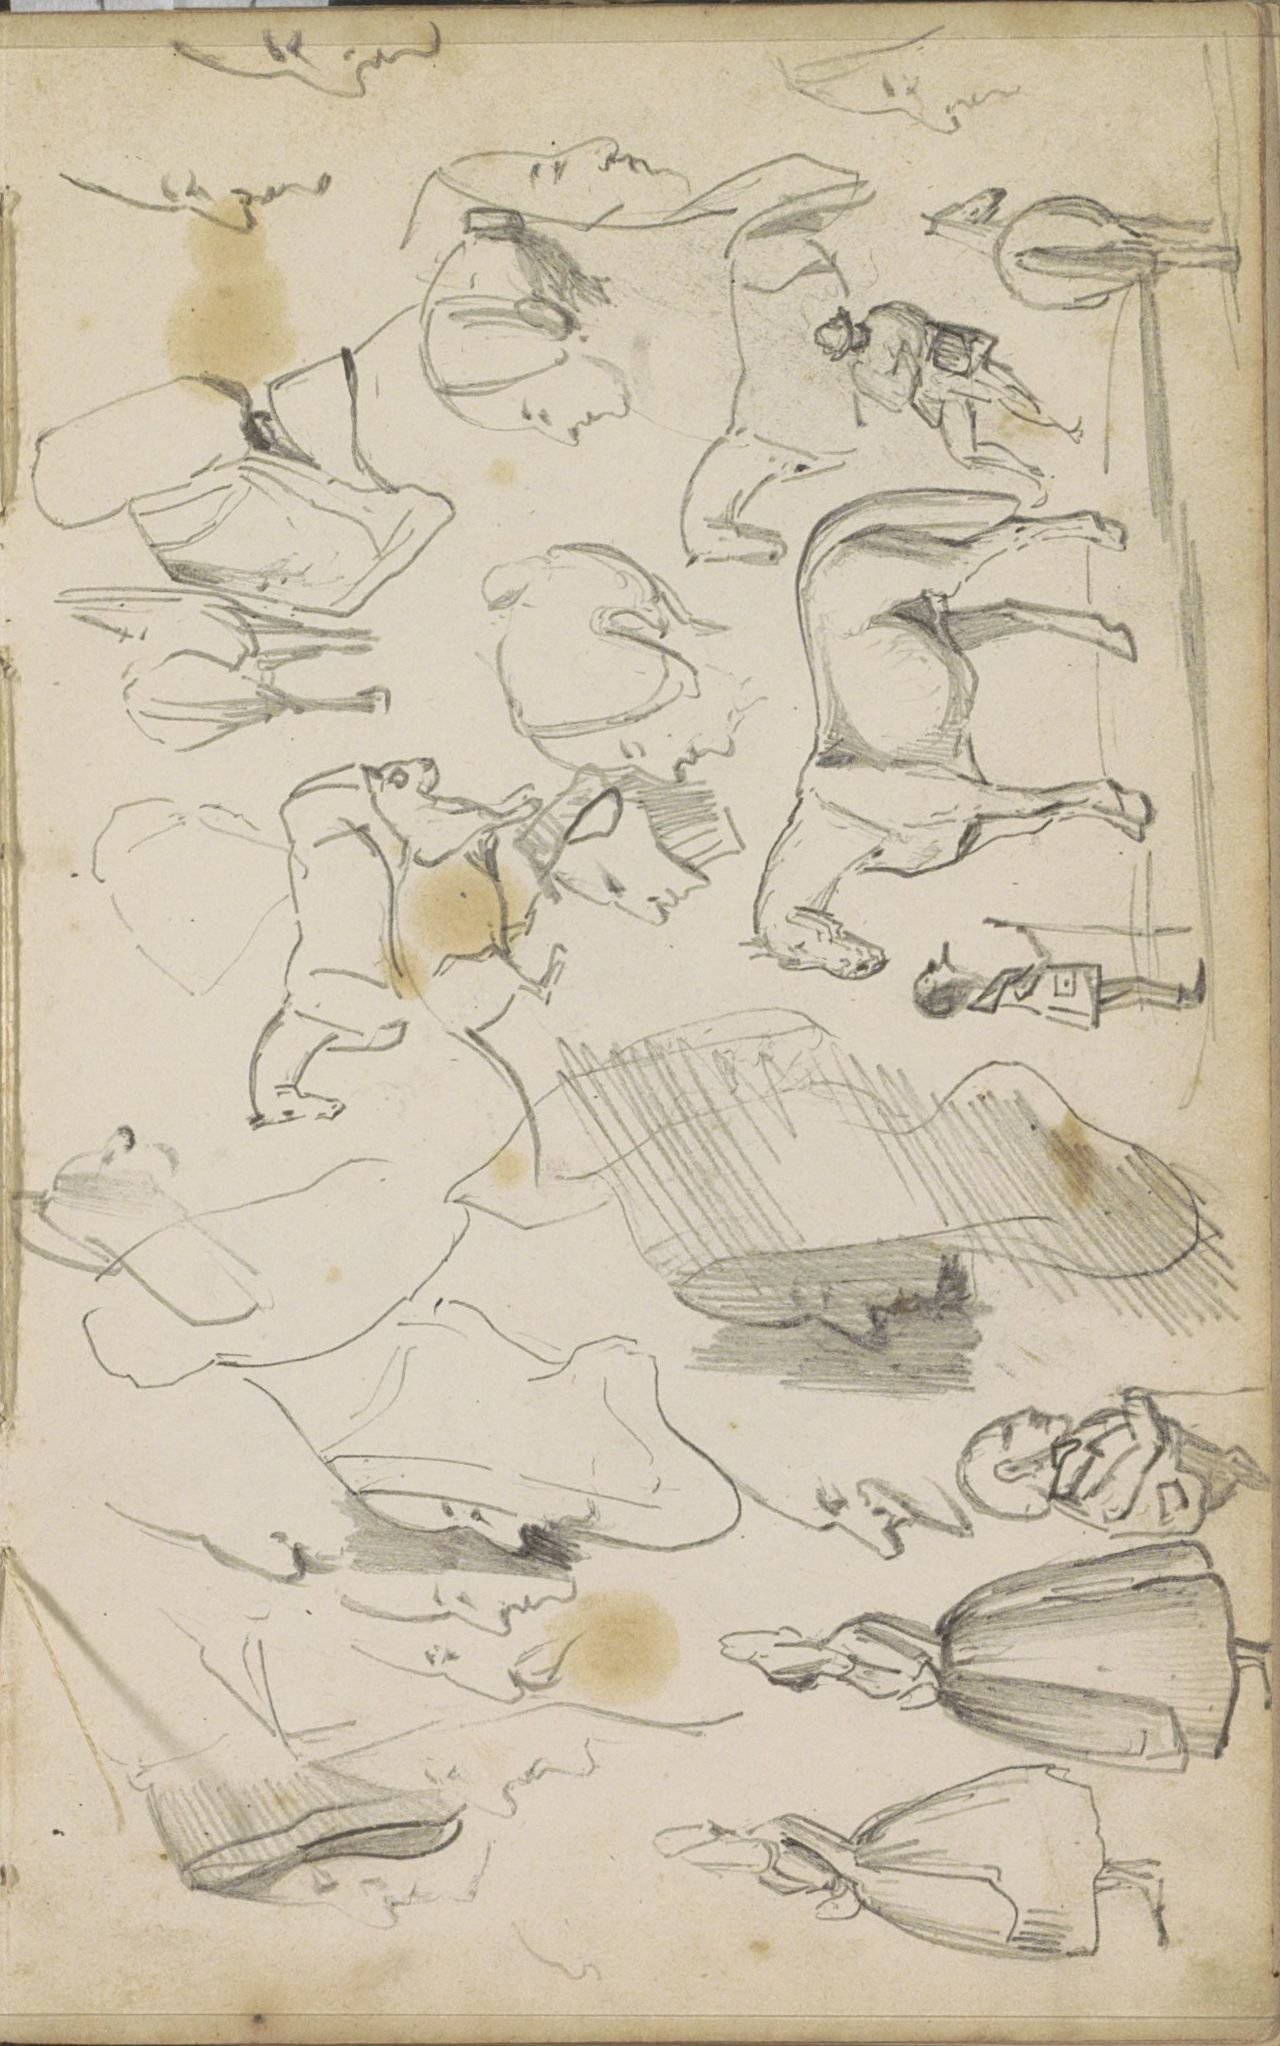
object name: sketchbook leaf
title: Paarden en vrouwen met kappen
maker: johannes tavenraat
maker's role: draughtsman, painter, print maker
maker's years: 1809-1881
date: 1839-1872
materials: paper, pencil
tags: head-gear: hat (+ women's clothes), horse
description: Blad 8 recto uit een schetsboek met 73 bladen.